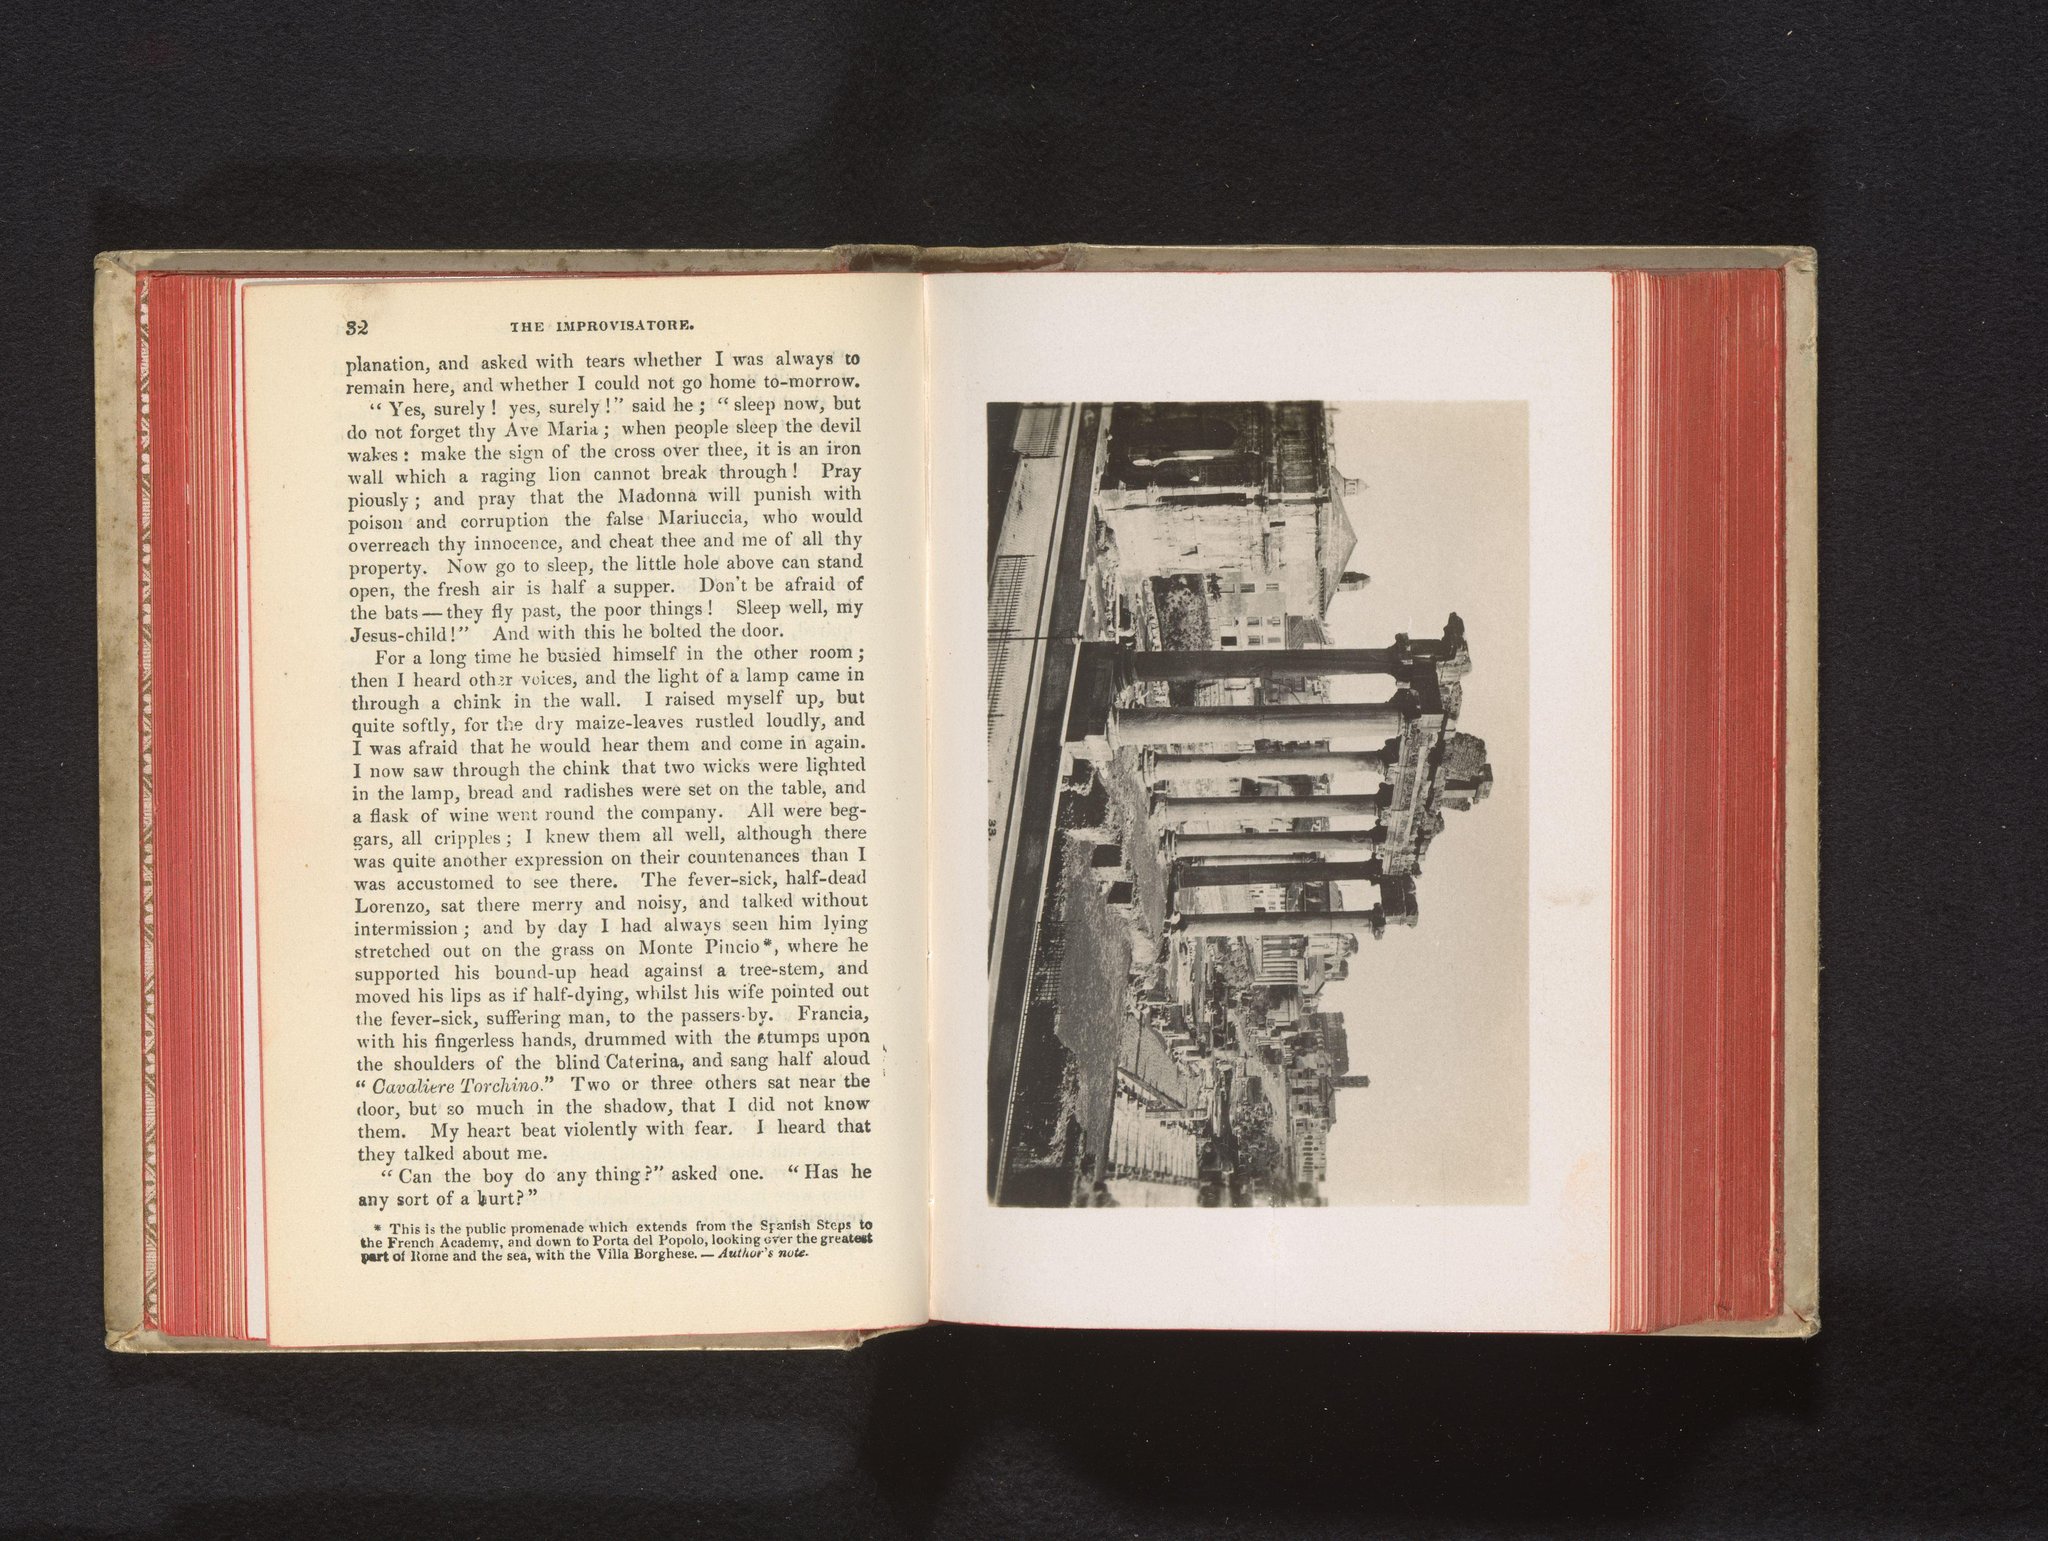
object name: page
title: Ruïne van de Tempel van Saturnus te Forum Romanum te Rome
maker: Anonymous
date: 1870-1880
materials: photographic support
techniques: gelatin silver print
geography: forum romanum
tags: ruin of a building ~ architecture, temple, shrine ~ roman religion